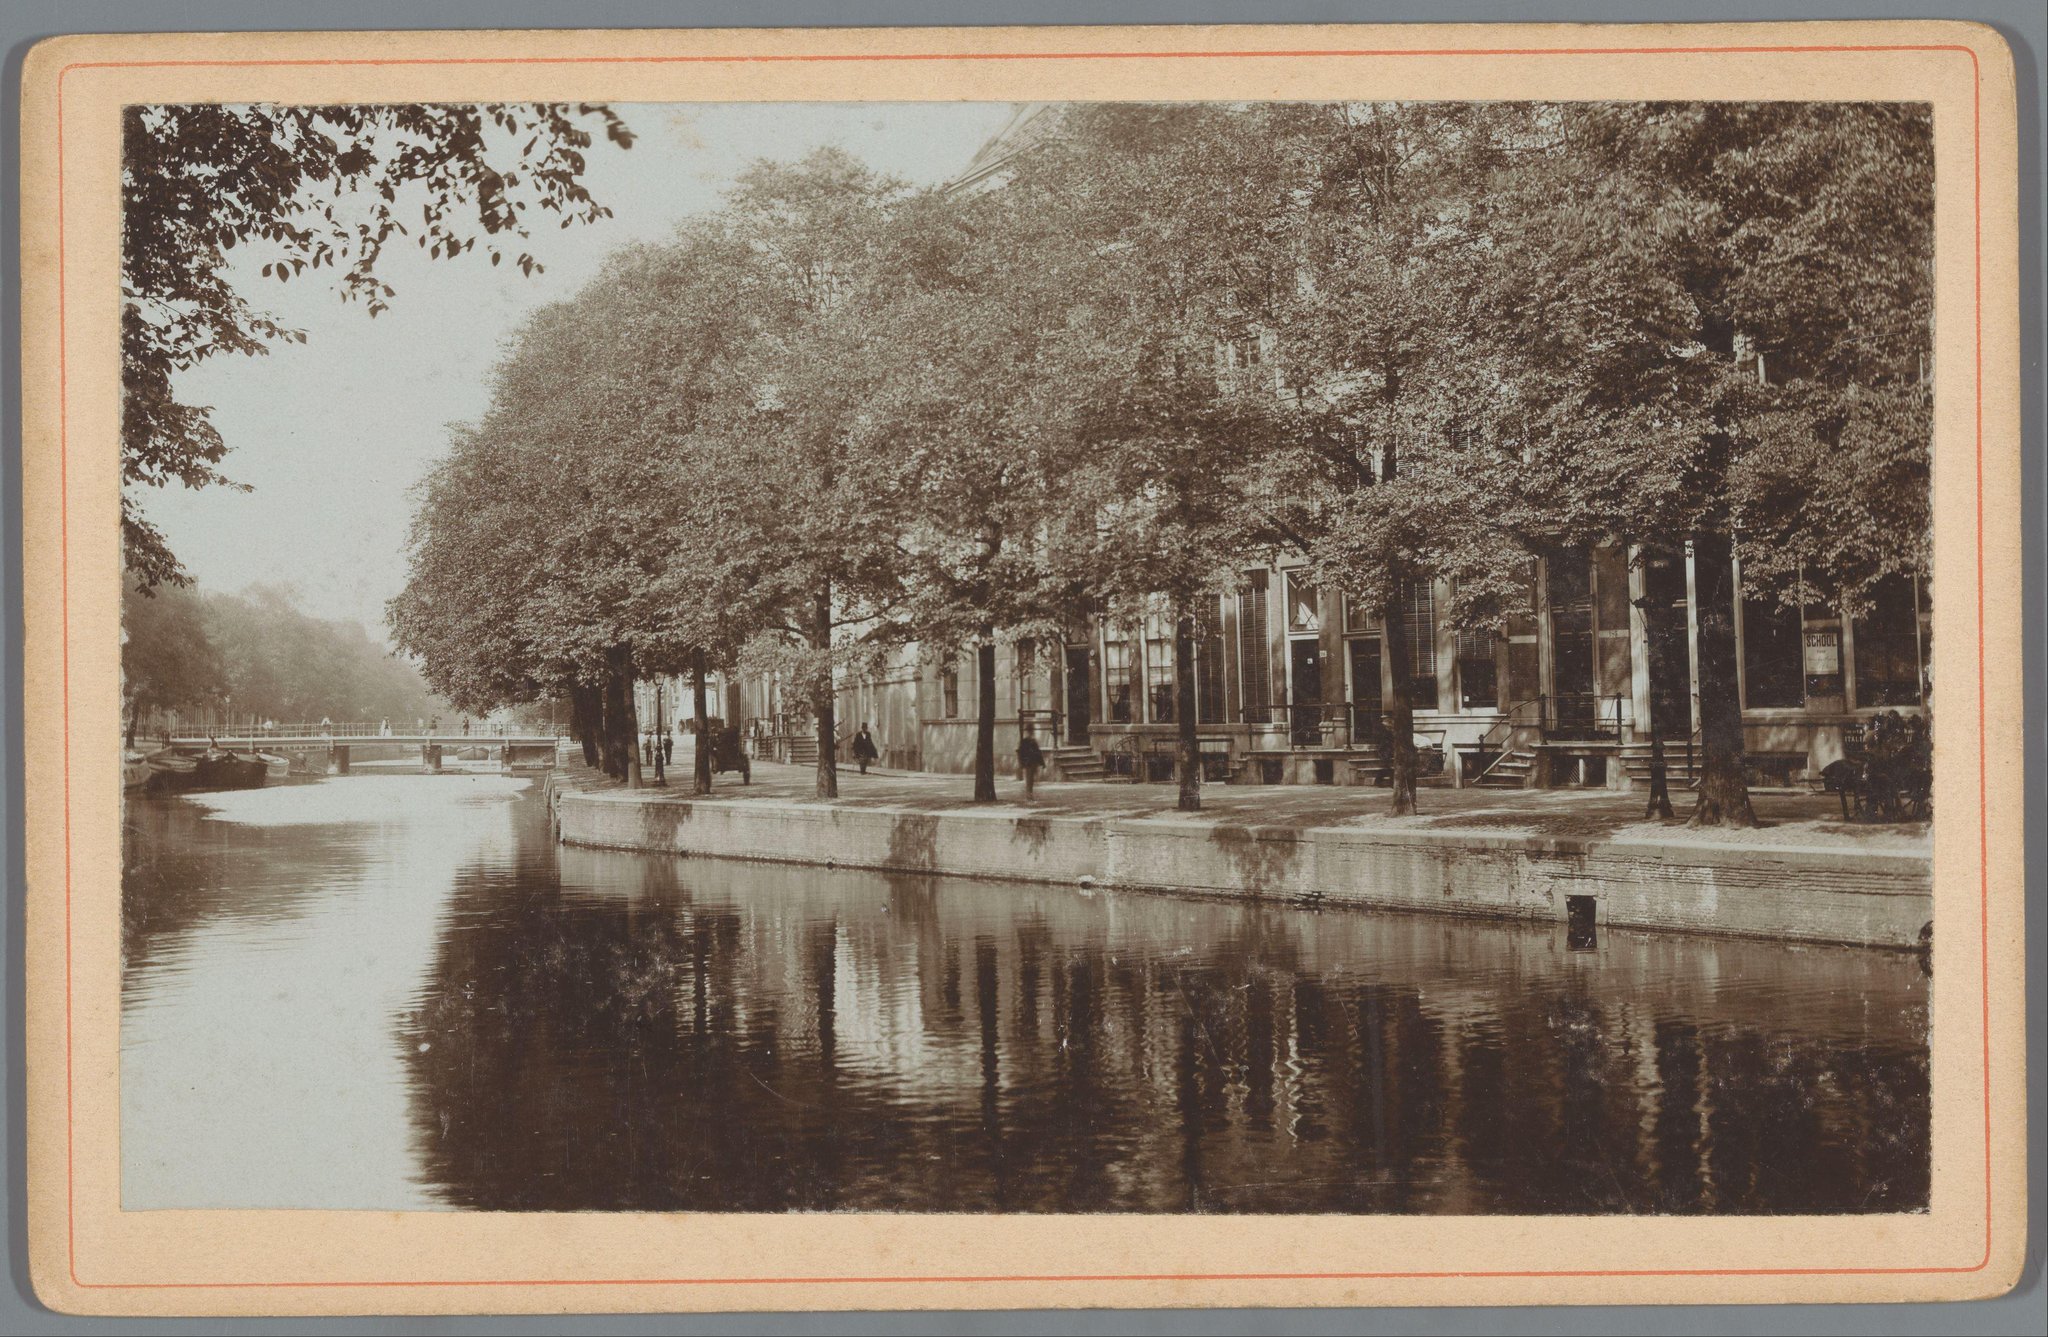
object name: cabinet photograph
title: Gezicht op de Keizersgracht in Amsterdam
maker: Anonymous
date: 1880-1900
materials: cardboard, photographic support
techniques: collodion silver print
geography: amsterdam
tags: trees, canals, waters (in city)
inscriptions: name: ‘Vosmaer’, number: ‘114’, inscription: ‘Voormalige Huizen aan de Keizersgracht [...] de Westermarkt. Afgebroken ten behoeve de Raadhuisstraat over de Gracht is thans een brug gbouwd.’